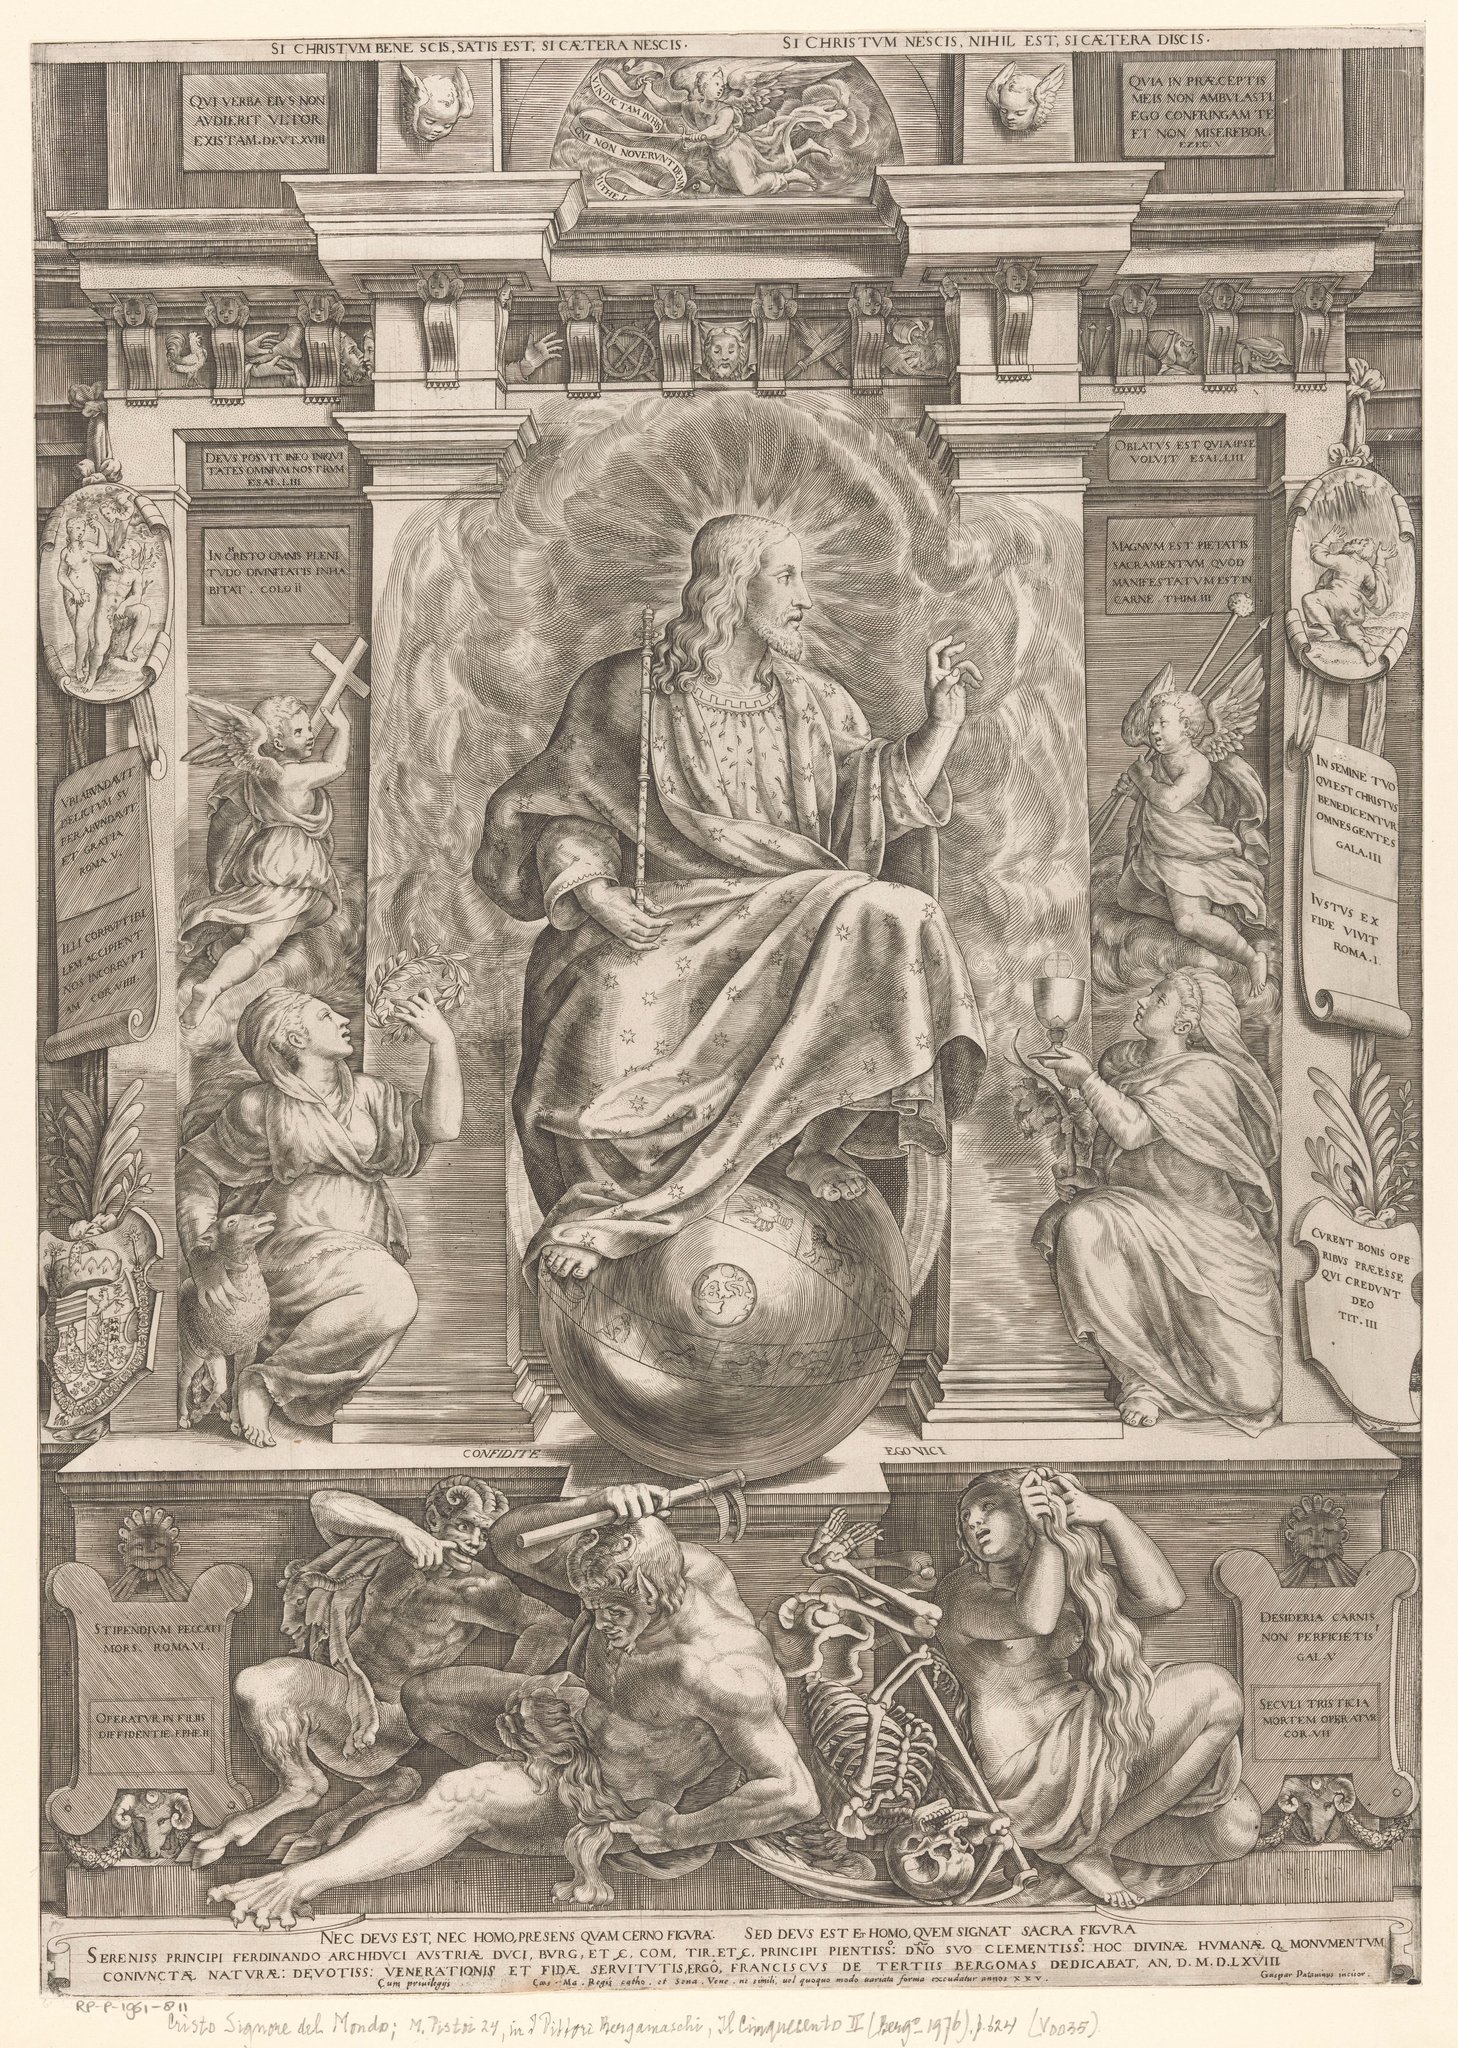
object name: print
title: Si Christum bene scis, satis est, si Caetera nescis./ Si Christum nescis, nihil est, si caetera discis (...)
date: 1568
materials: paper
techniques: engraving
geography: italy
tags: inscription, devil(s) and demons, christ, (human) skeleton, female saints, angels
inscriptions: collector's mark: Lugt 2228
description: Christus zittend op de wereldglobe met een scepter in zijn rechterhand. Met zijn linkerhand maakt hij een zegenend gebaar. Hij wordt aan weerszijden geflankeerd door een vrouwelijke heilige en een engel. Hij bevindt zich voor een architectonische nis met verschillende inscripties en schilden. Onder bevinden zich duivelse figuren en een skelet. Boven een engel met een zwaard en een banderol met tekst. Opdracht in het Latijn in ondermarge.